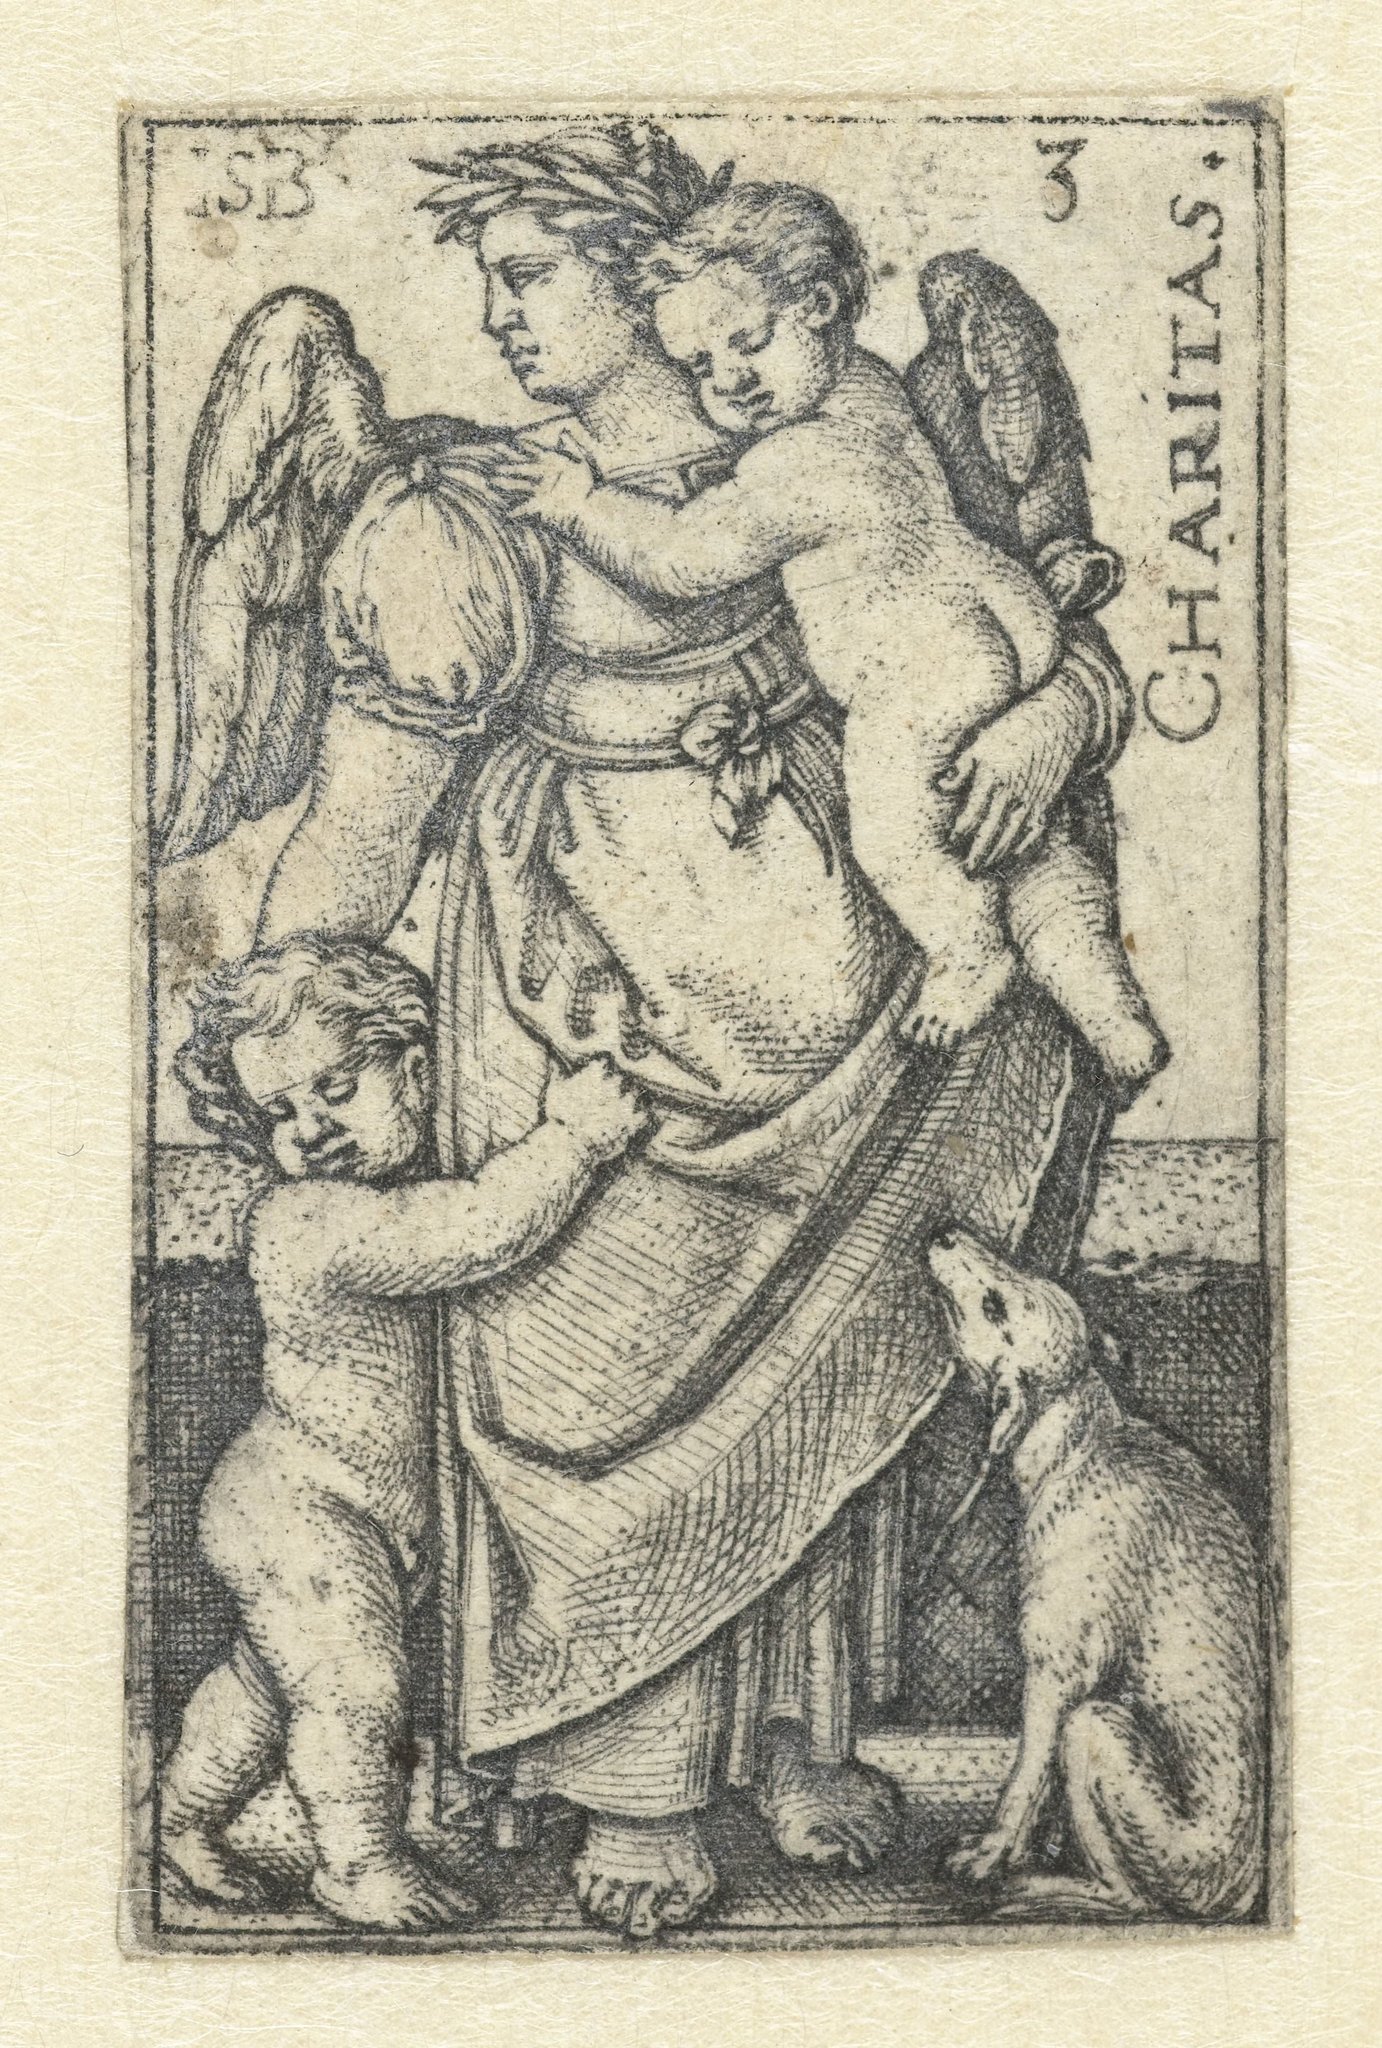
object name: print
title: Kennis en Zeven Deugden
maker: hans sebald beham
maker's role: designer, draughtsman, print maker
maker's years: 1500-1550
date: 1539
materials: paper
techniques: engraving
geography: frankfurt am main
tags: charity, 'caritas'; 'carità' (ripa) ~ one of the three theological virtues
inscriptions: collector's mark: Lugt 2911, collector's mark: Lugt 2228a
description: Gevleugelde vrouw als personificatie van de Liefde (Caritas) met twee kinderen en een hond